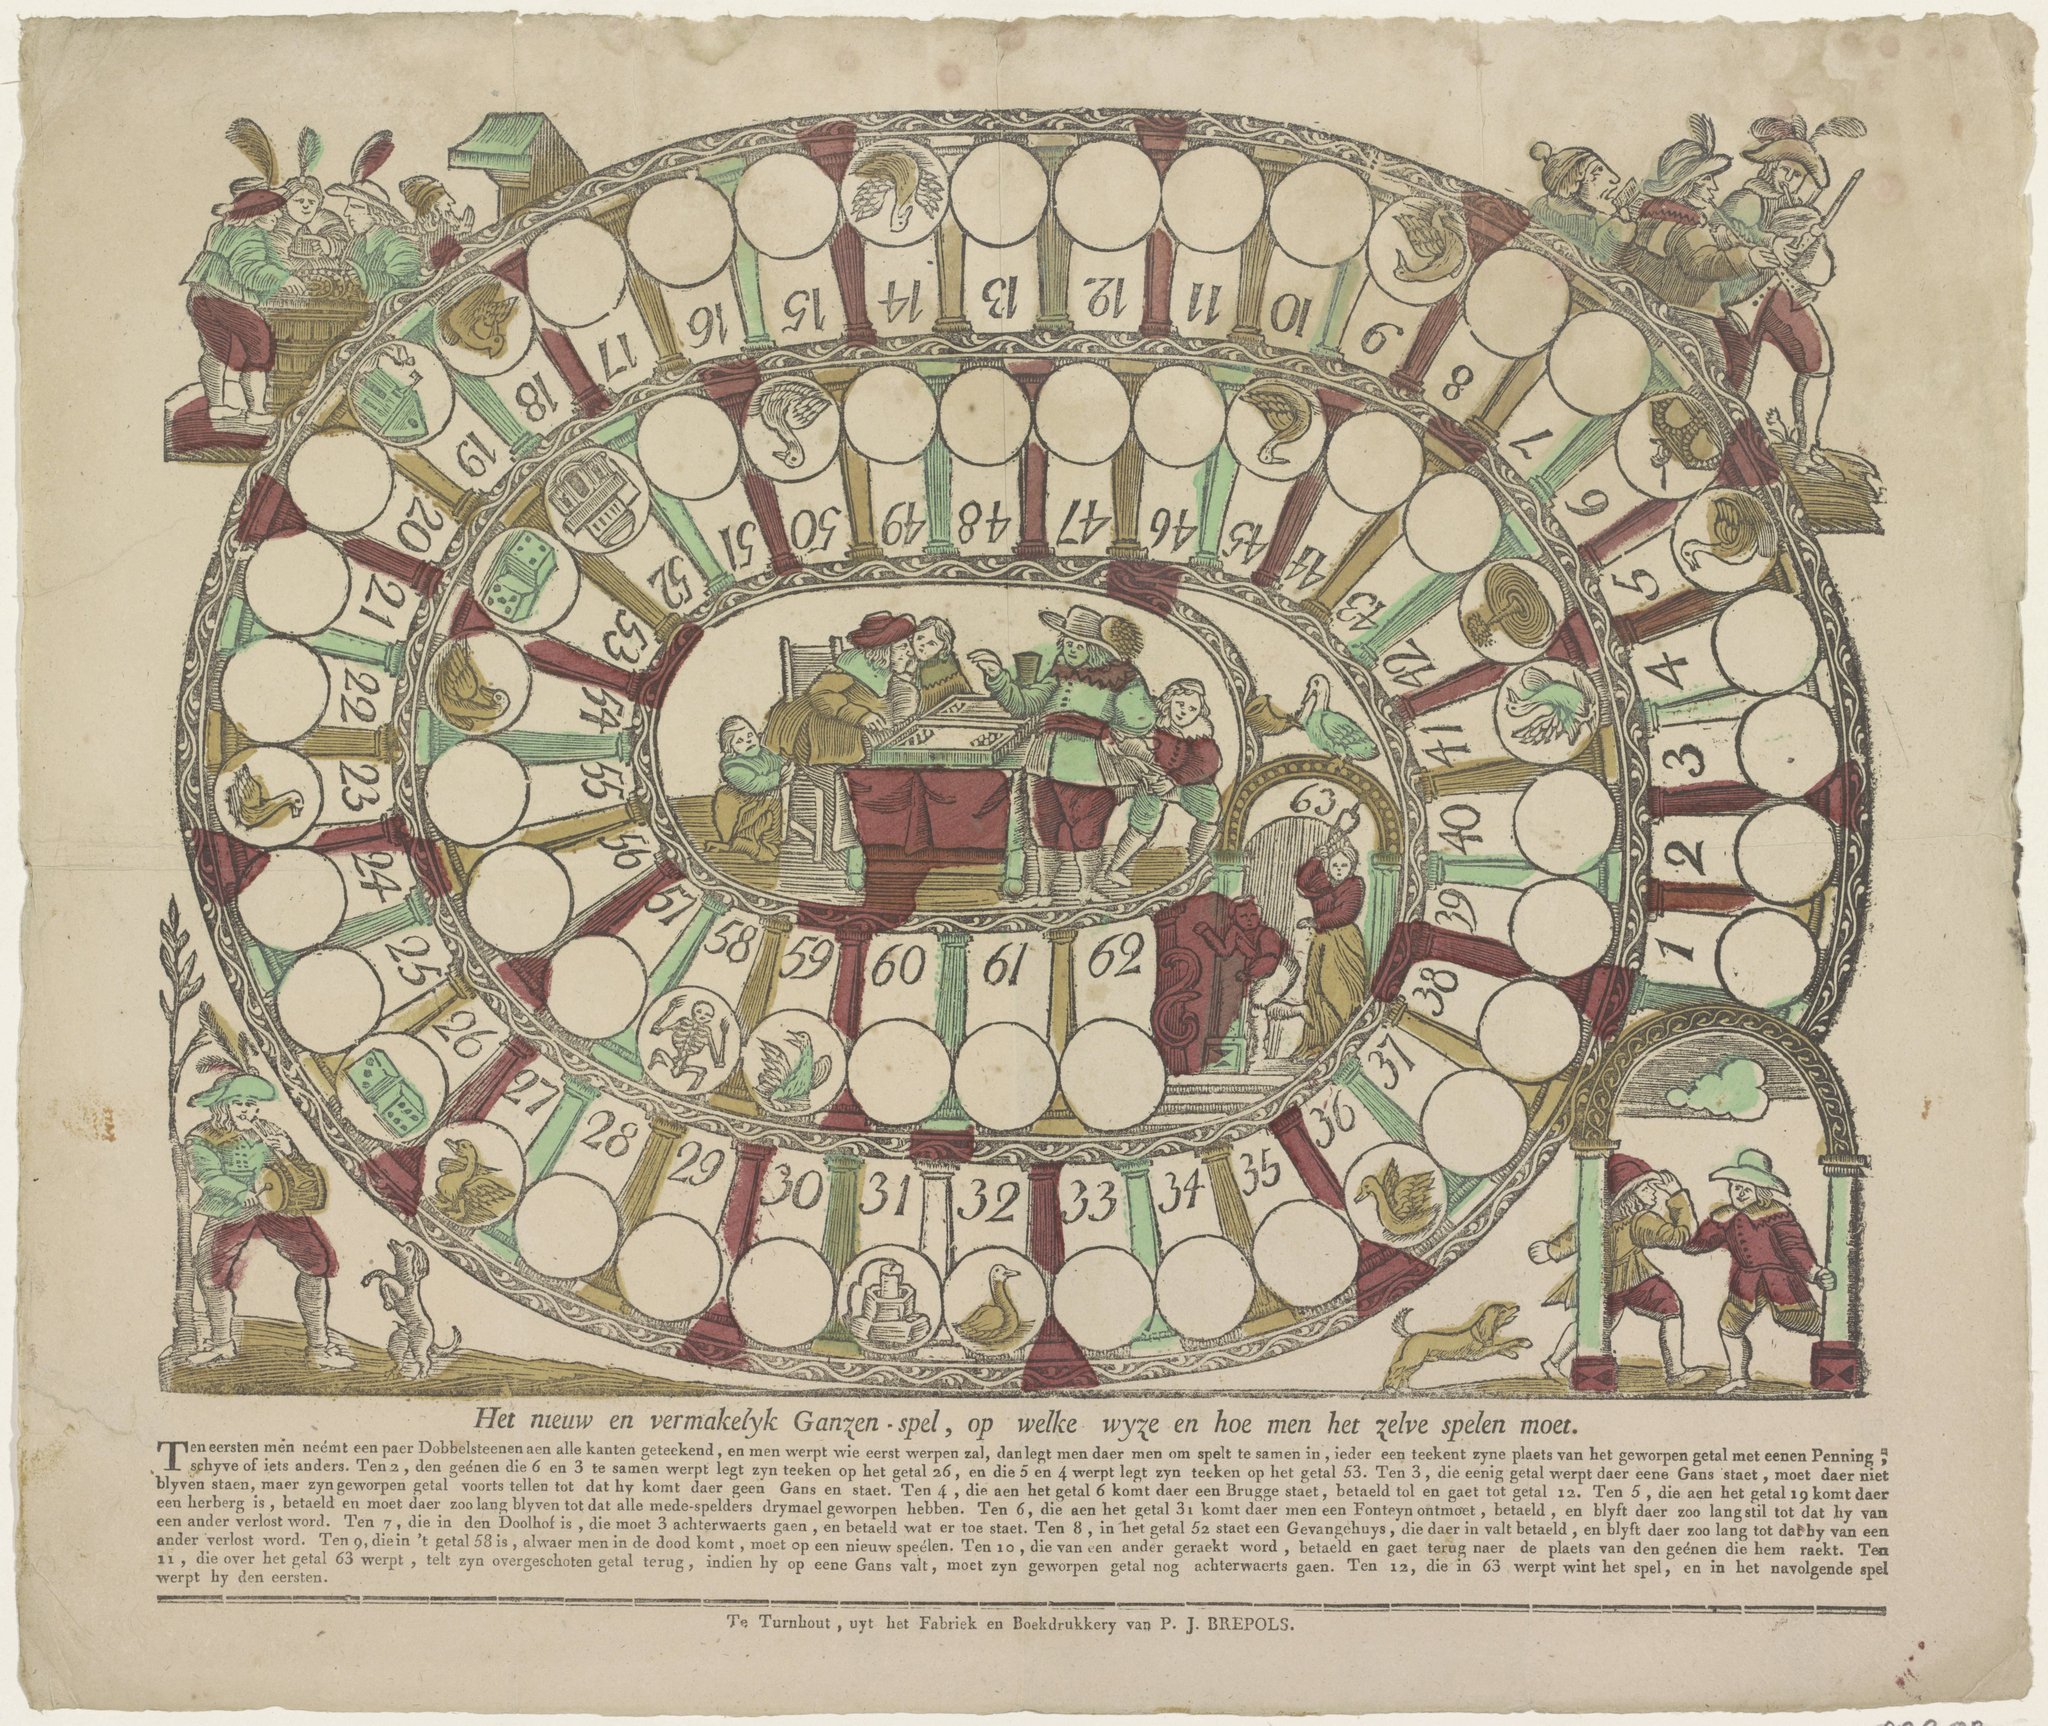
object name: gameboard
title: Het nieuw en vermakelyk ganzen-spel, op welke wyze en hoe men het zelve spelen moet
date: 1800-1833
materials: paper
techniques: colour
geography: turnhout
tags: goose-game, board-games of chance, board-games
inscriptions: collector's mark: Lugt 2760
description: Ovaal ganzenbordspel met vakjes genummerd 1-63. In het midden een herberg/bordeelscène met twee mannen, een vrouw en twee kinderen rond een tafel, de mannen spelen backgammon. In de vier hoeken van het spel mannen die muziek maken, dansen en spelletjes spelen. Onder de voorstelling de spelregels.